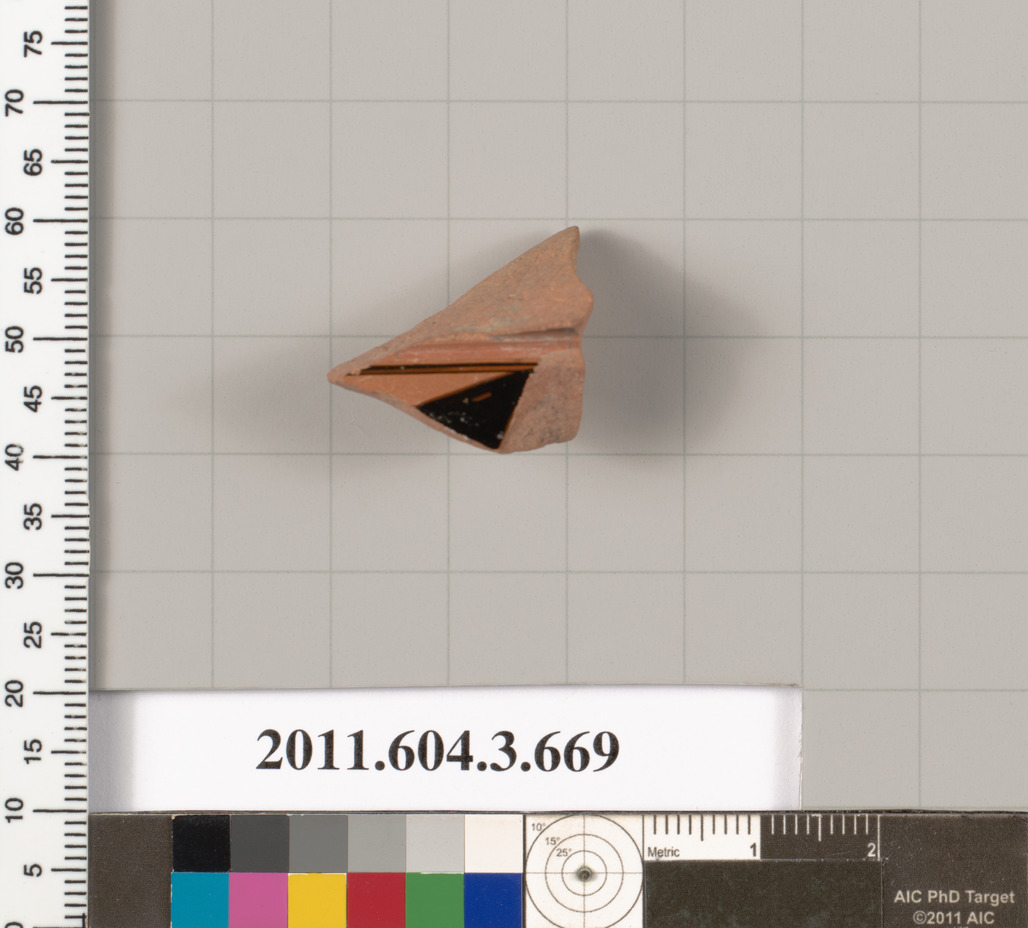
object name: volute krater fragment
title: Terracotta fragment of a volute-krater (bowl for mixing wine and water)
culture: greek, attic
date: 550-501 BCE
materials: terracotta